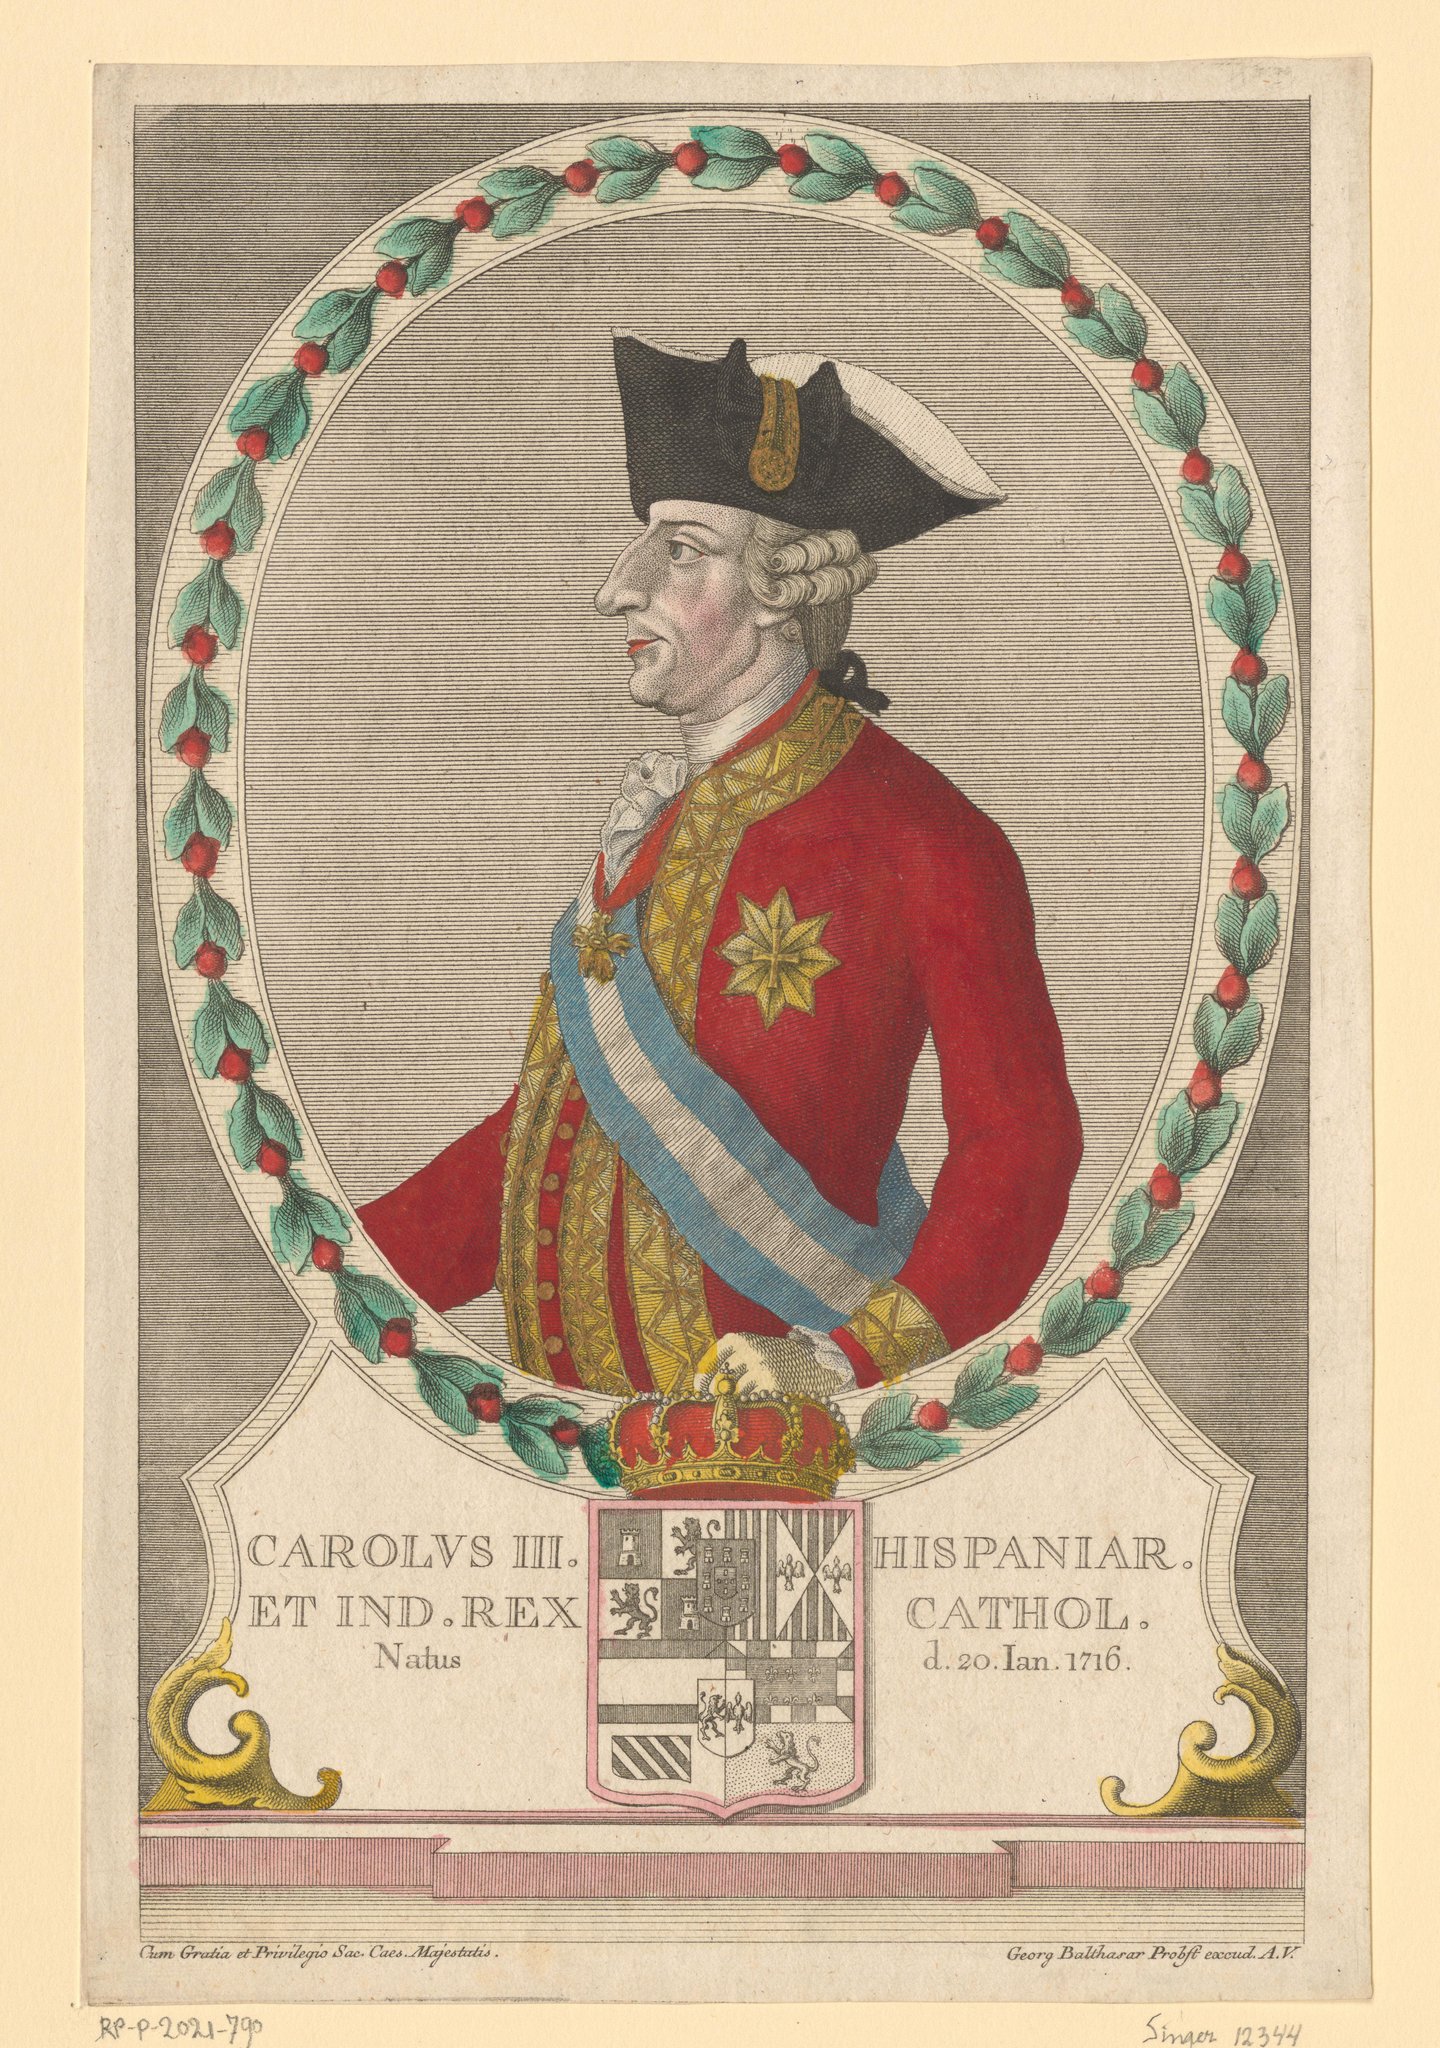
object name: print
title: Portret van Karel III, koning van Spanje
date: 1766-1790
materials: paper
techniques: engraving, etching, hand coloring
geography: holy roman empire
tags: karel iii (koning van spanje (1716-1788), historical persons, knighthood order of the golden fleece, king, armorial bearing, heraldry